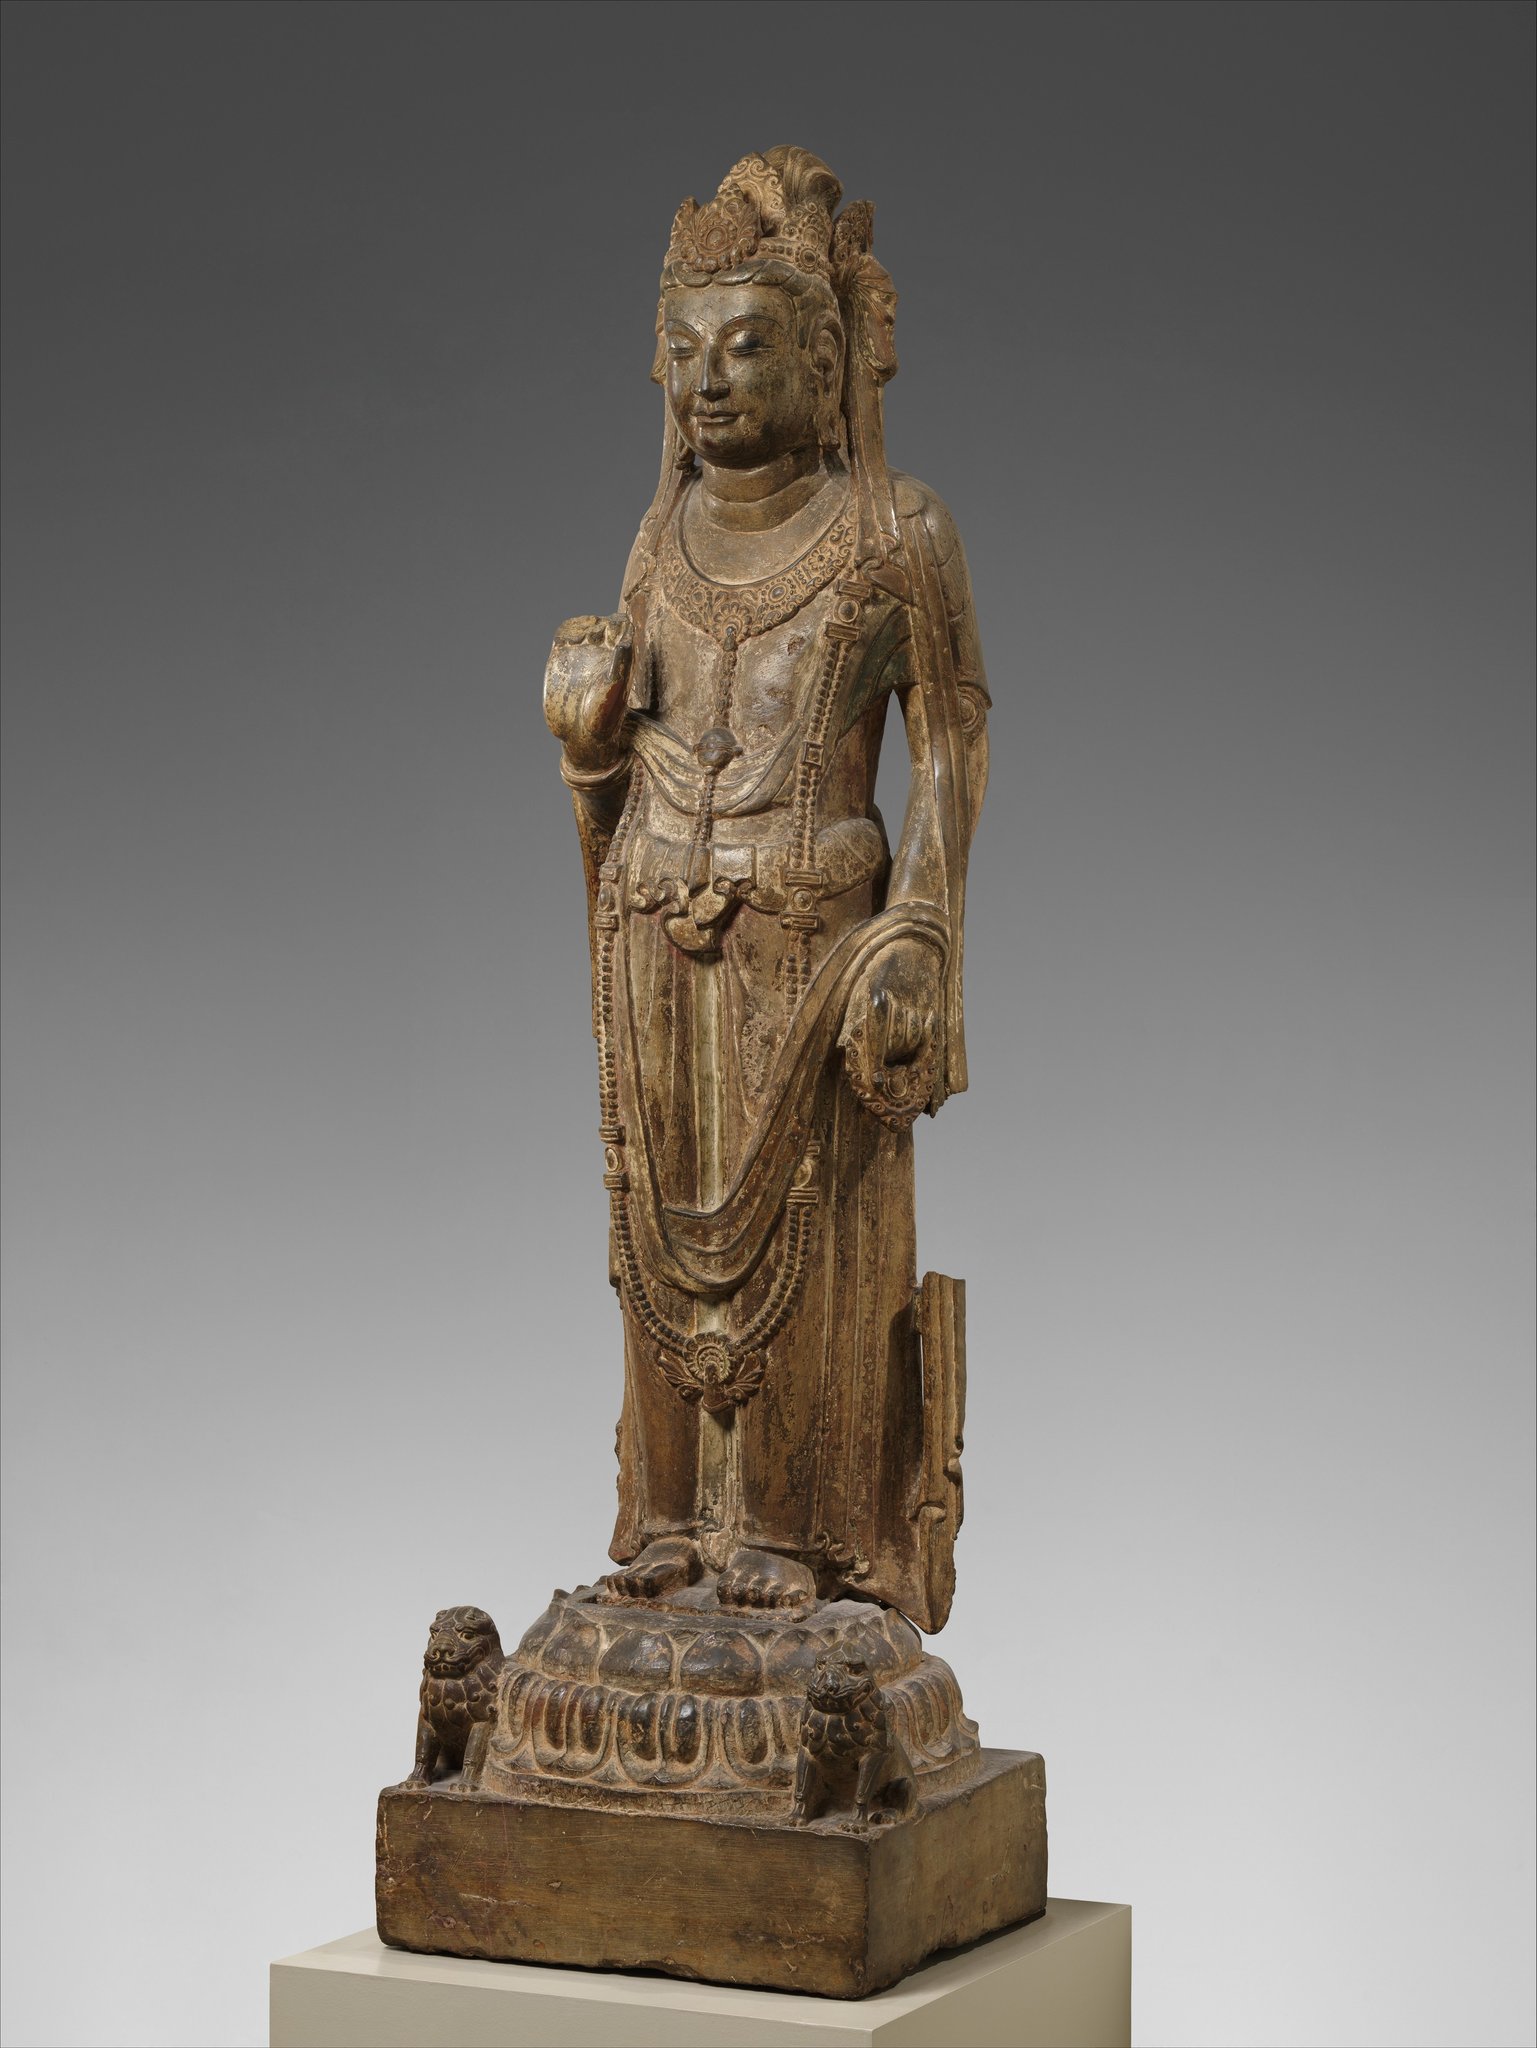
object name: figure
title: Bodhisattva, probably Avalokiteshvara (Guanyin)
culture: chinese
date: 567-600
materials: limestone, pigment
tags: buddhism,avalokiteshvara,bodhisattvas